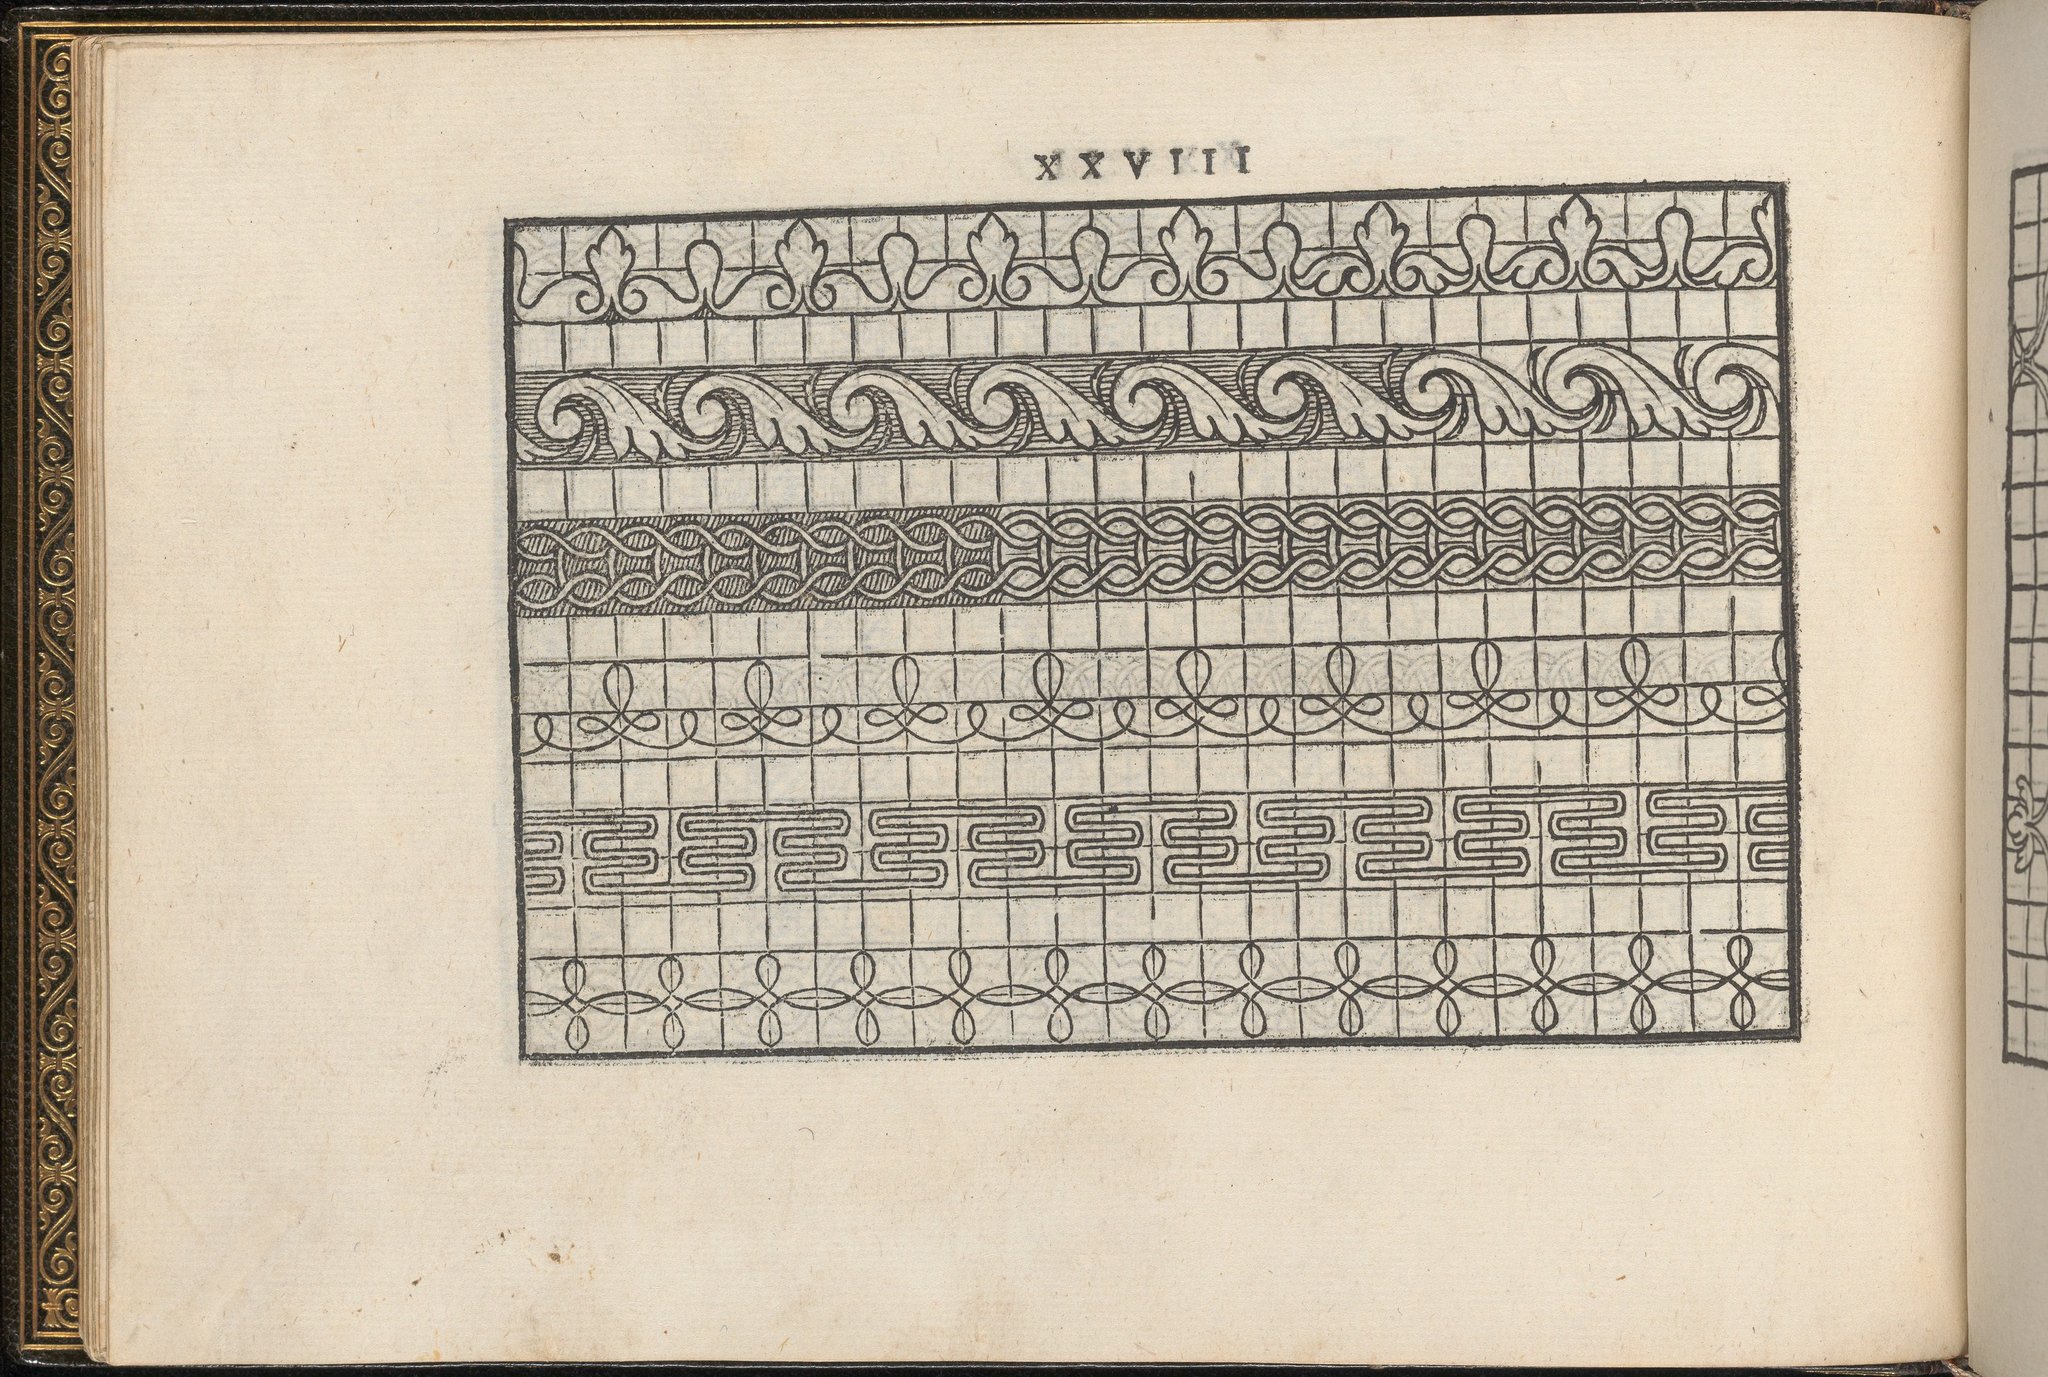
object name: book print ornament architecture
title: La Vera Perfettione del Disegno di varie sorti di recami, page 14 (verso)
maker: giovanni ostaus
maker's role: publisher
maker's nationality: italian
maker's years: 1507-1607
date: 1567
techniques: woodcut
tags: flowers